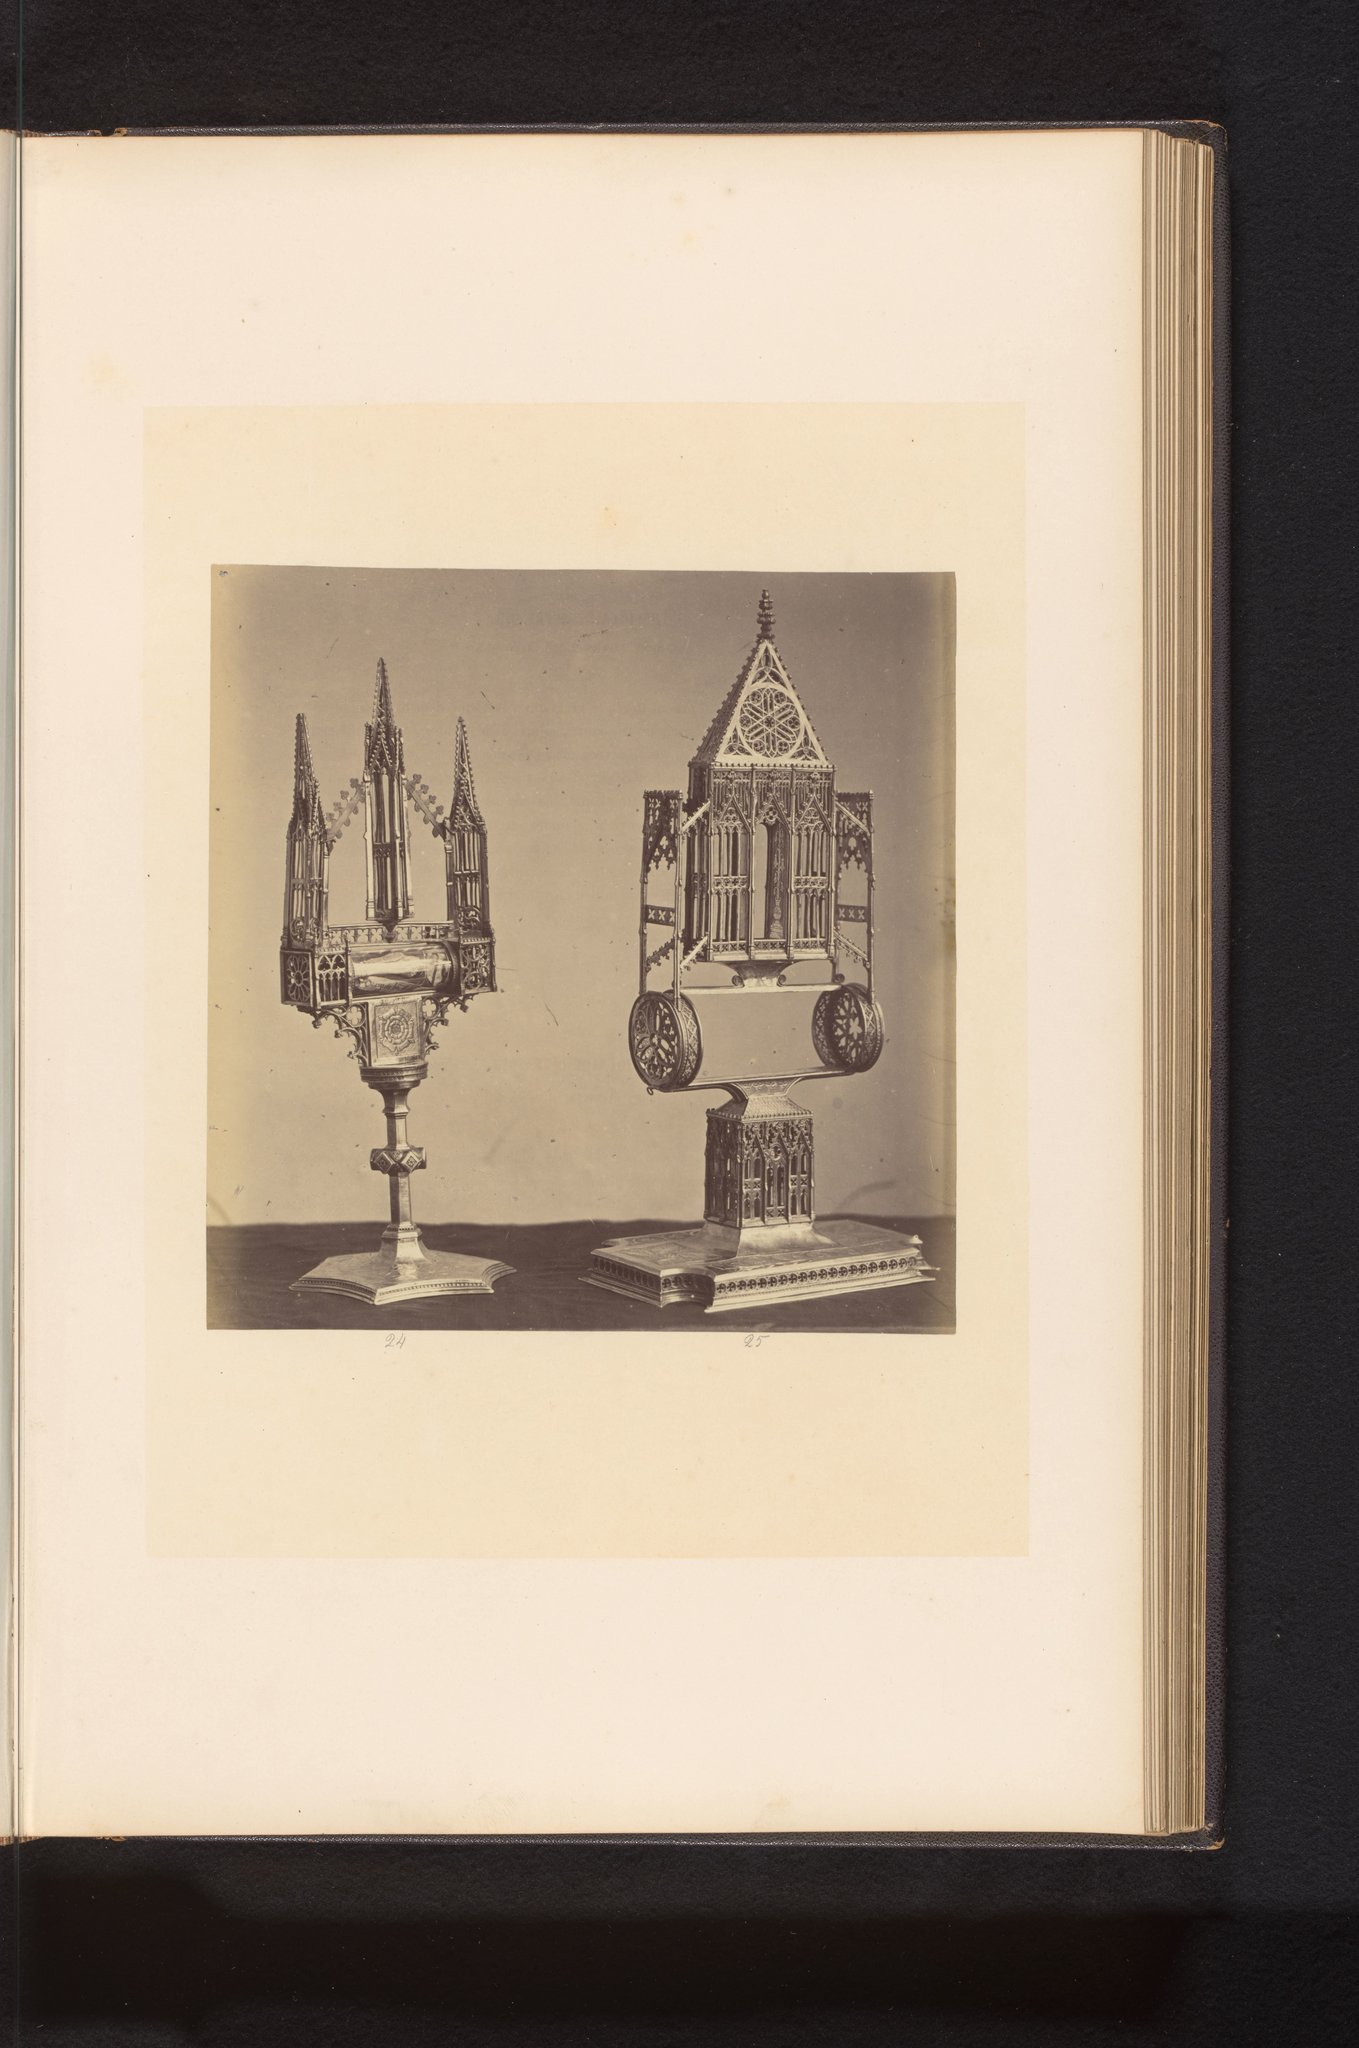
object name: page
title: Twee zilveren monstransen, opgesteld op een tentoonstelling over religieuze objecten uit de middeleeuwen en renaissance in 1864 in Mechelen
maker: joseph maes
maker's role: fotograaf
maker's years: 1838-1908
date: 1864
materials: photographic support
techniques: albumen print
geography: mechelen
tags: ostensorium, monstrance, relics (and reliquaries), mechelen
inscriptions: number: ‘24 - 25’